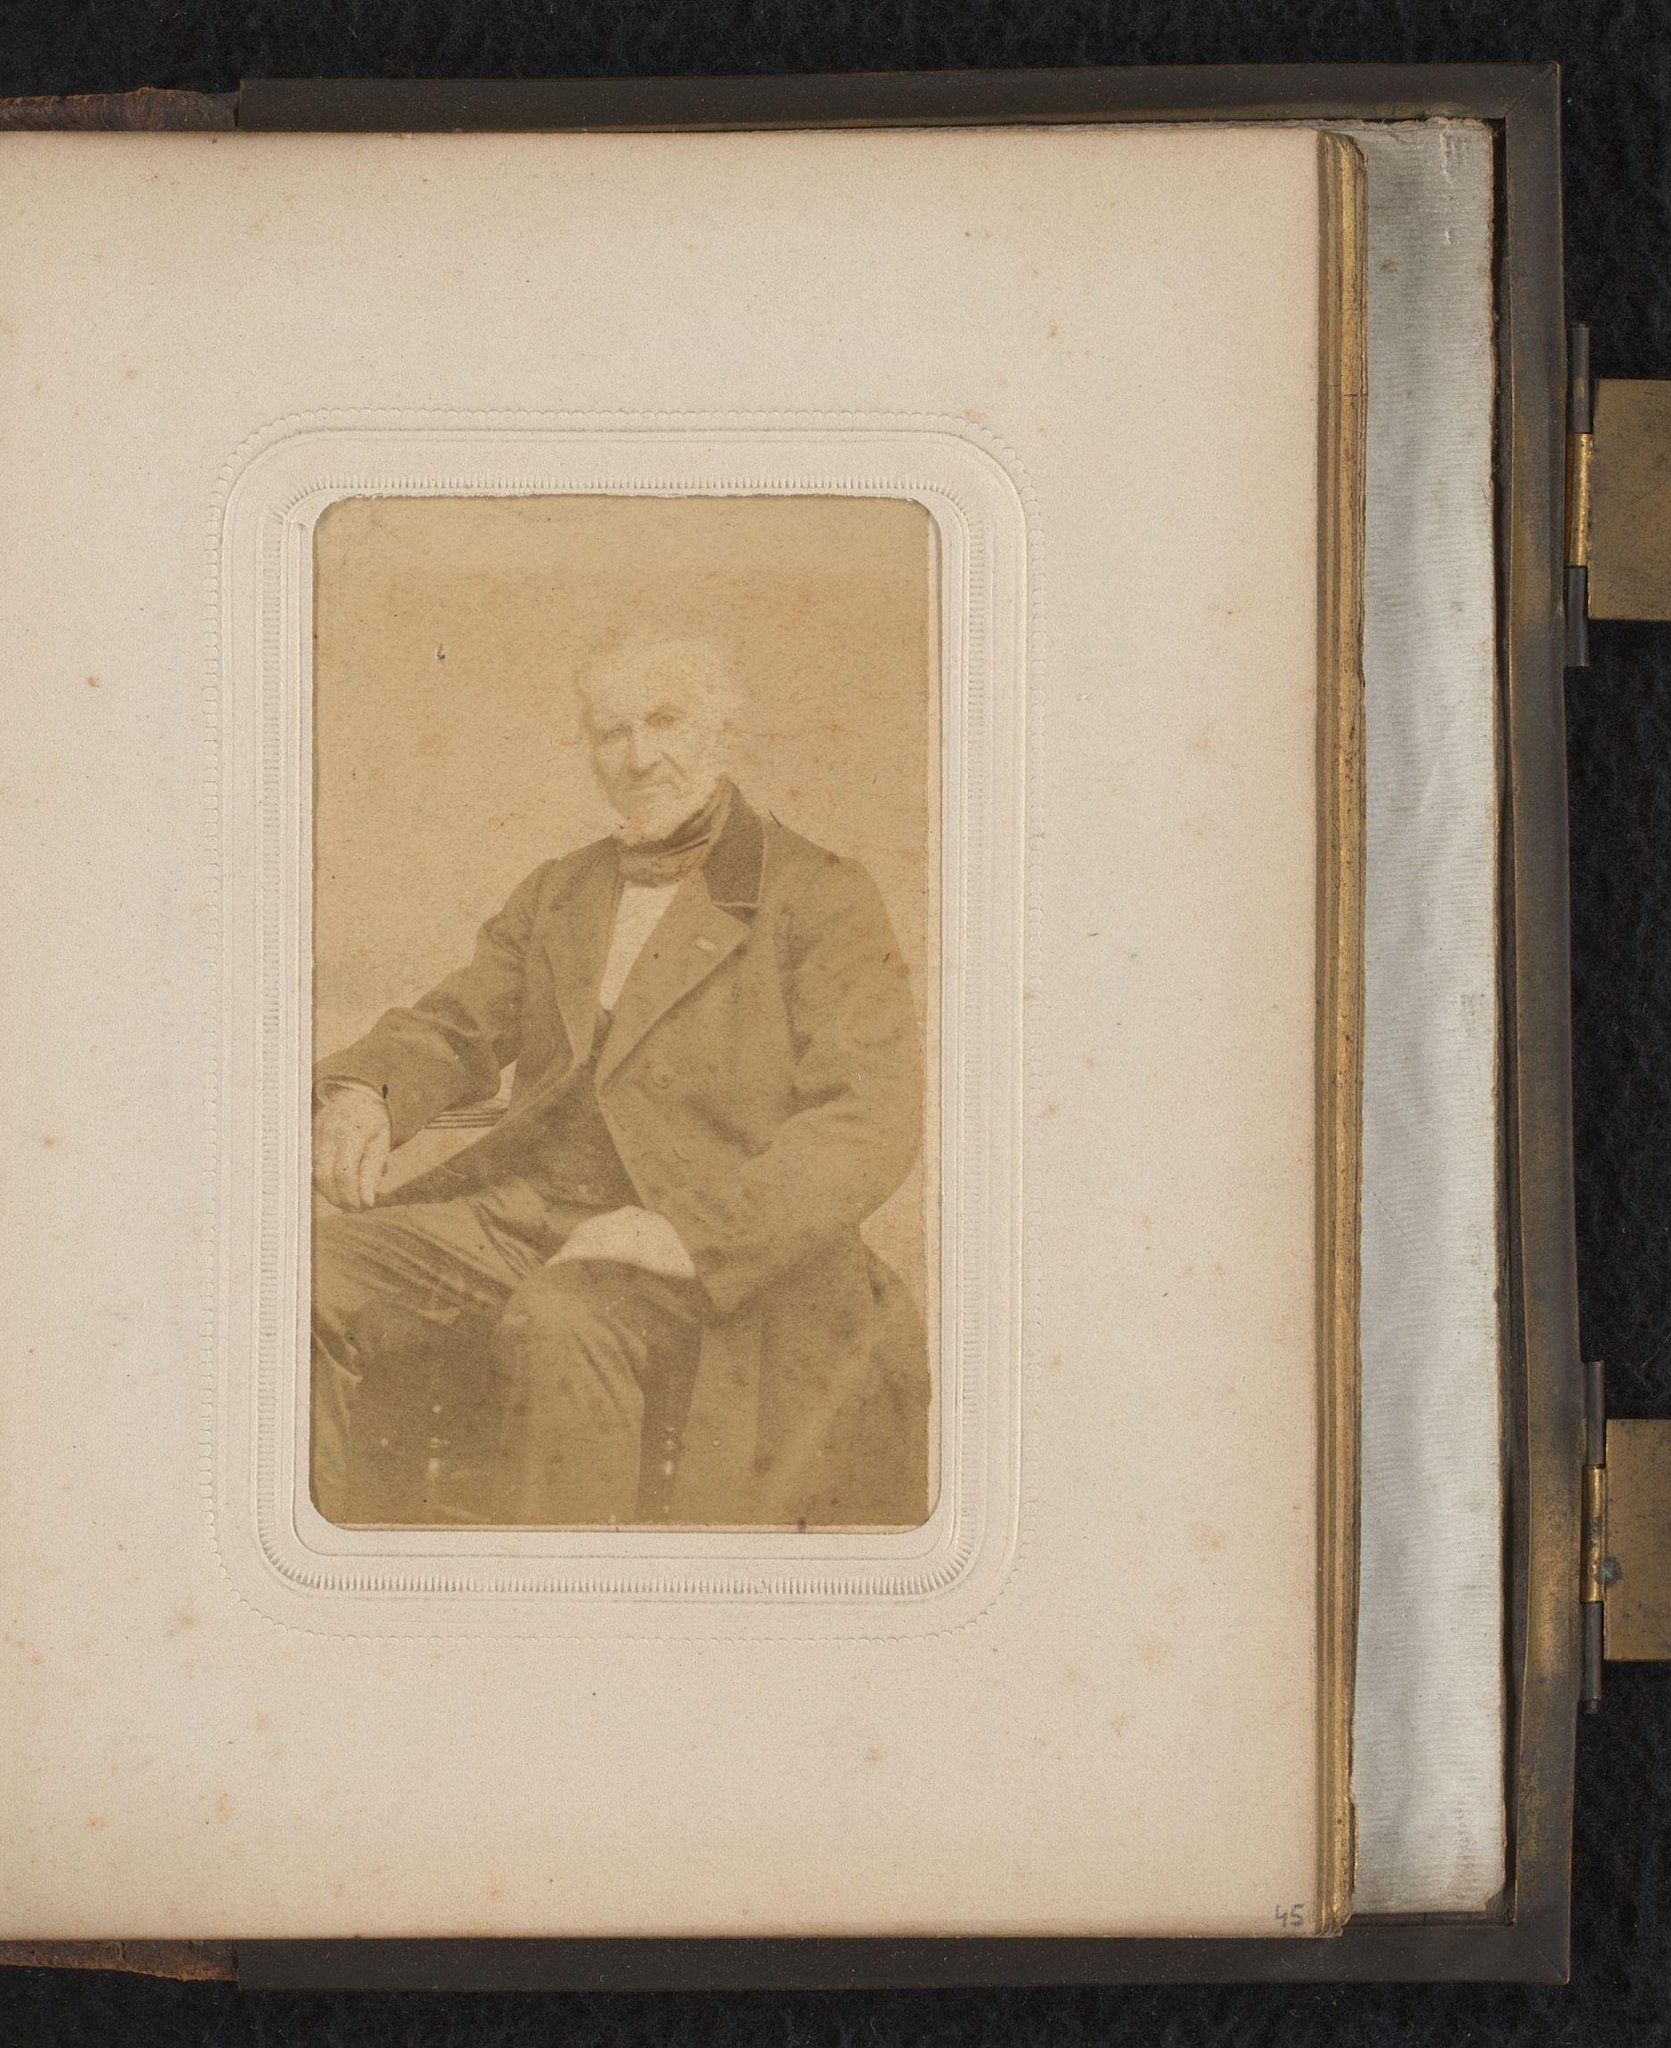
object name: album leaf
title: Portret van een zittende man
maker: léon rosse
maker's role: fotograaf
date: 1860-1900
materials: cardboard, photographic support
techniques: albumen print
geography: saint-malo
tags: sitting figure, historical persons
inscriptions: inscription: ‘LÉON ROSSE/ Rue St Vincent/ St MALO’